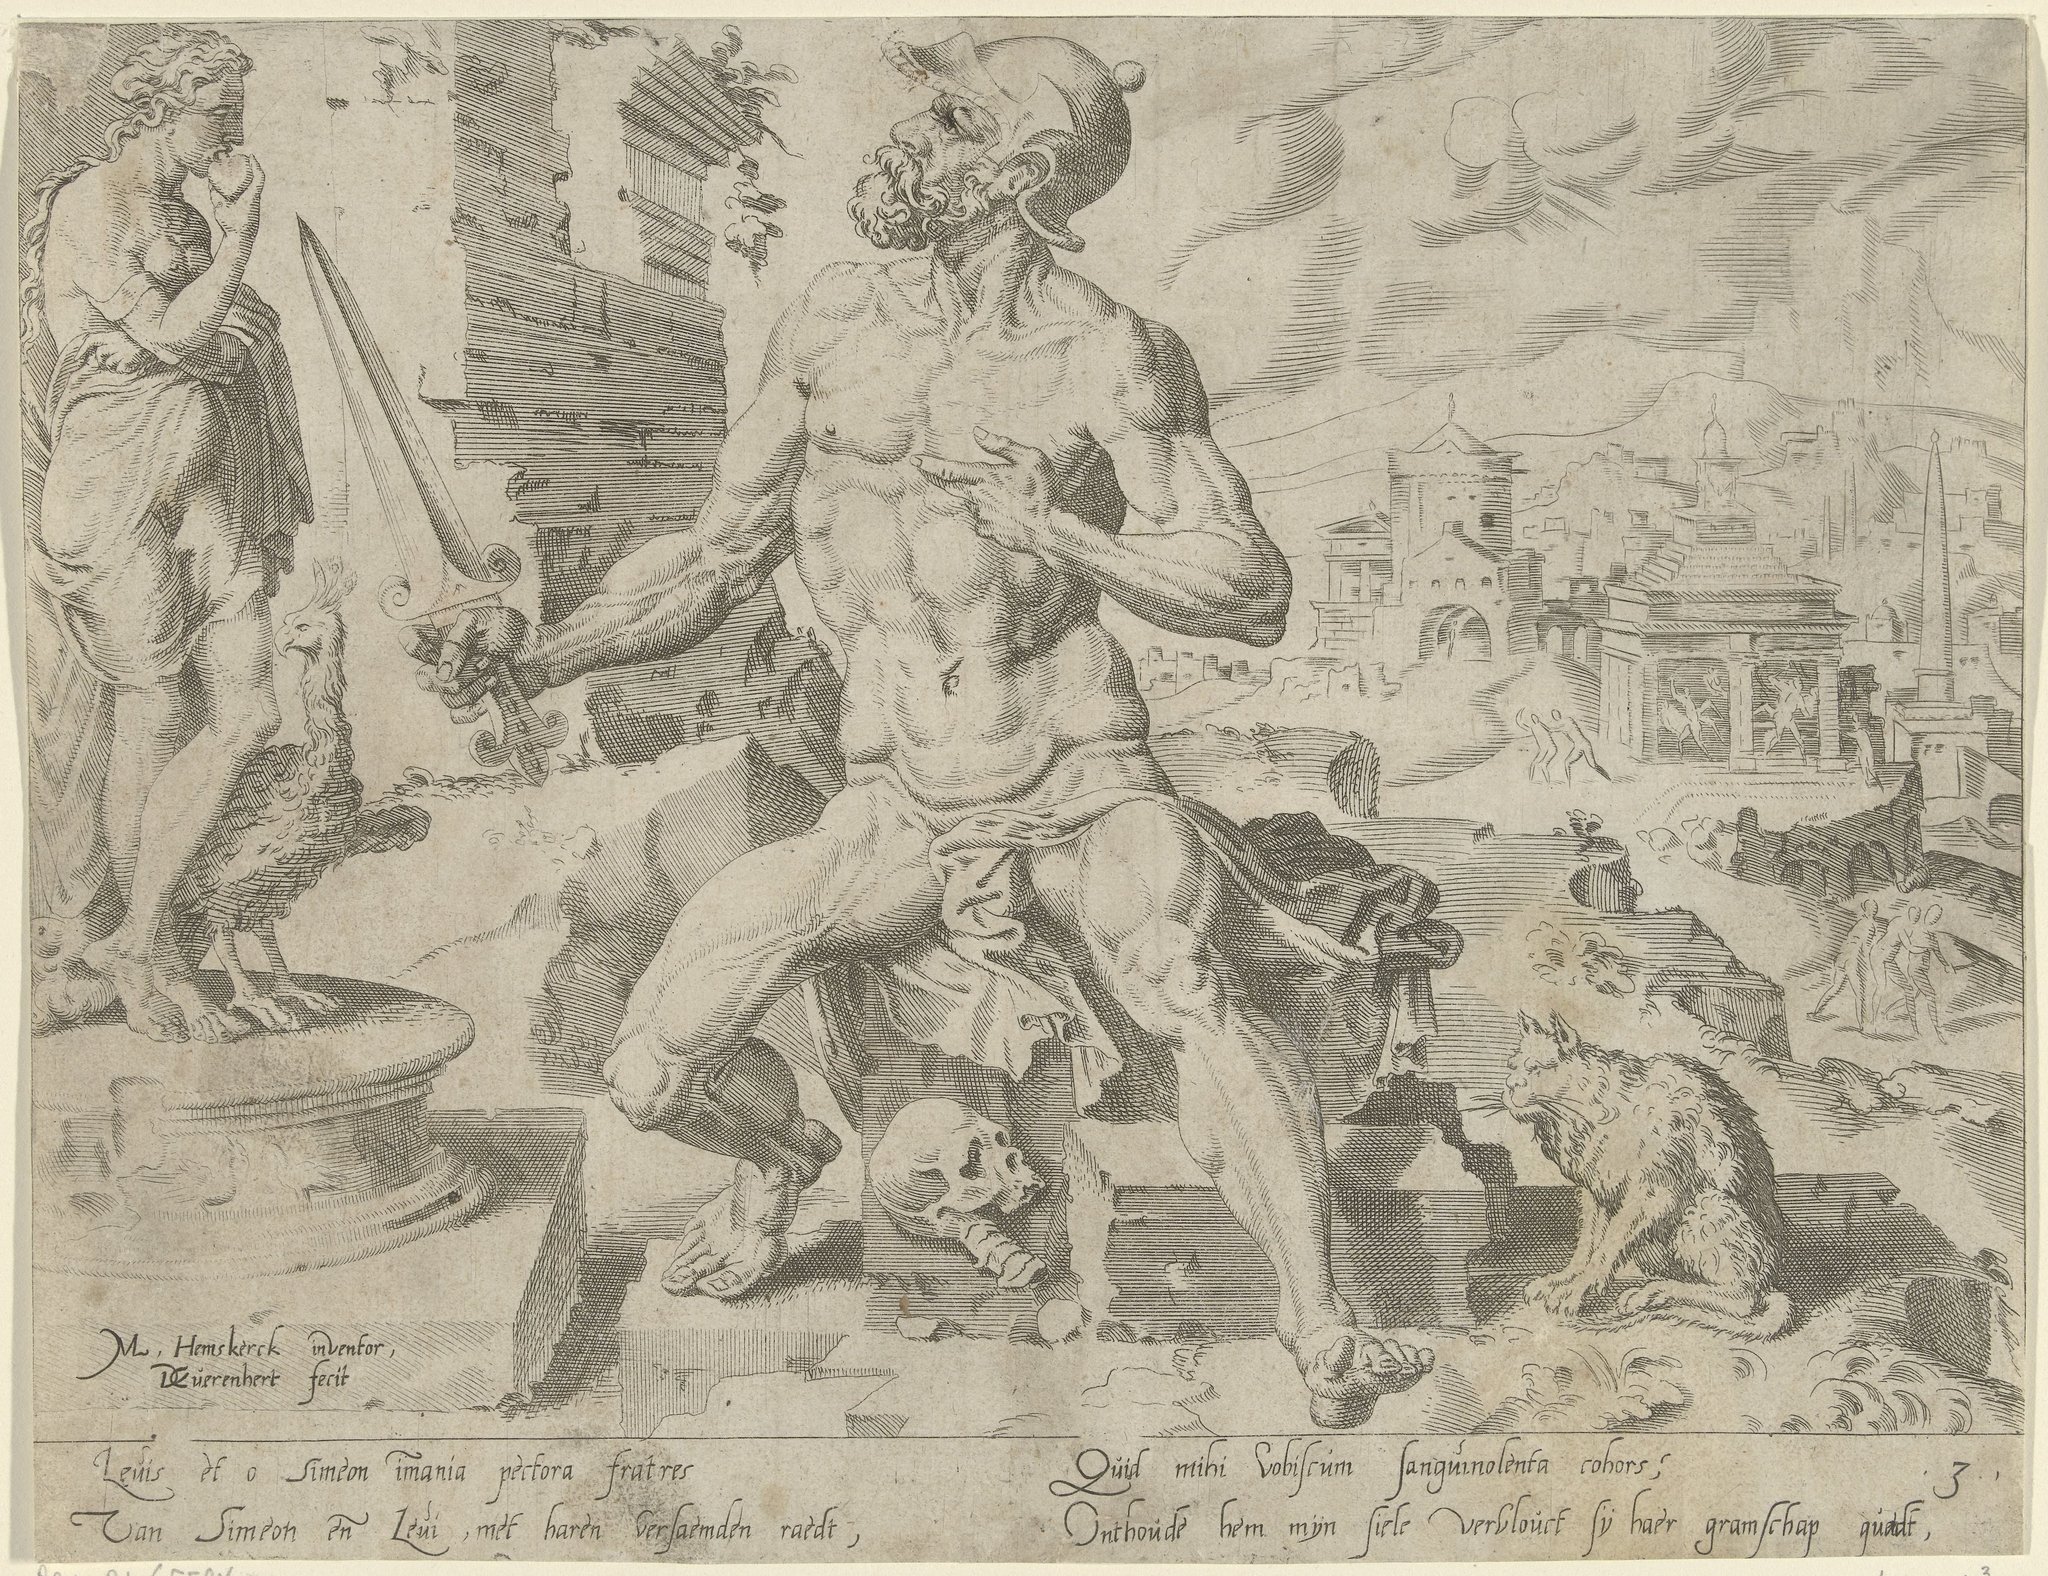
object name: print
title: Twaalf zonen van Jakob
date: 1550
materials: paper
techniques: engraving, etching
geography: haarlem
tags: jacob blesses his sons, cat (+ animals used symbolically), invidia (envy) as roman personification, male persons from the old testament (with name) (not in biblical context)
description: Simeon, de tweede zoon van Jakob. Een kater zit naast hem. Simeon wordt afgebeeld met helm en zwaard. Hij kijkt naar het standbeeld van Afgunst (Invidia), symbool voor de jaloezie van Simeon tegenover zijn broer Jozef. Al deze attributen verwijzen naar de Jakobs zegening van Simeon in Genesis 49. De prent maakt deel uit van een serie over de twaalf zonen van Jakob en patriarchen van Israël en heeft een Nederlands en Latijns onderschrift.